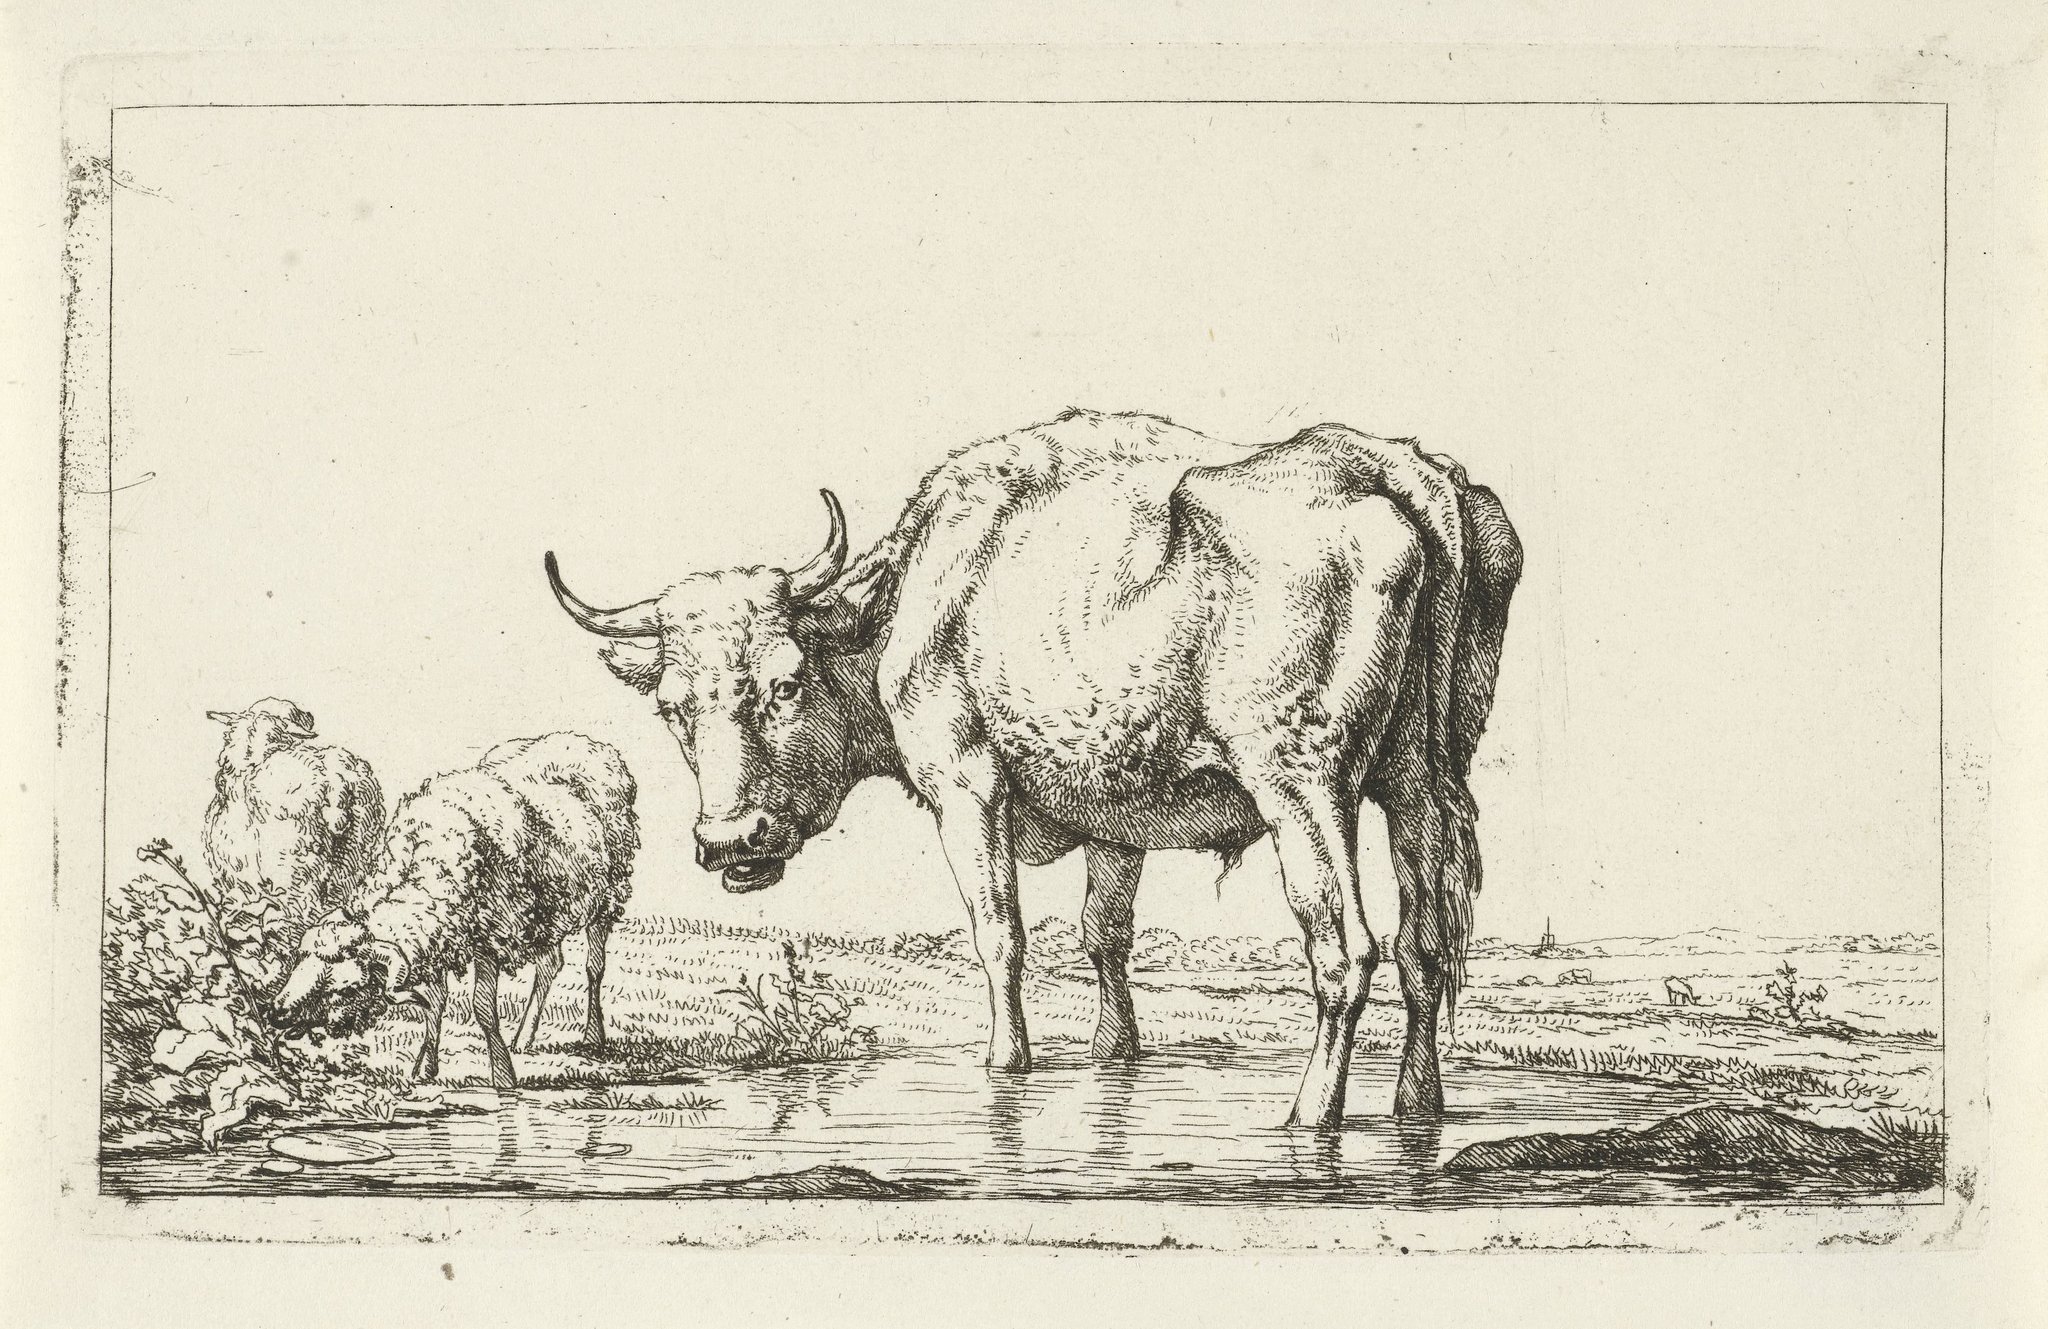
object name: print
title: Twee schapen en een stier bij een waterplas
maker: jan kobell (ii)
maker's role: draughtsman, painter, print maker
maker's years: 1778-1814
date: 1788-1814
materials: paper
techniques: etching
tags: cow, ram, sheep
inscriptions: collector's mark: Lugt 2228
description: In een landschap staat een stier tot zijn enkels in een waterplas, zijn kop is naar de toeschouwer gedraaid. Aan de rand van de plas staan een ram en een schaap; de ram eet van een distelstruik. Op de achtergrond staat vee te grazen en is een kerktoren te zien.